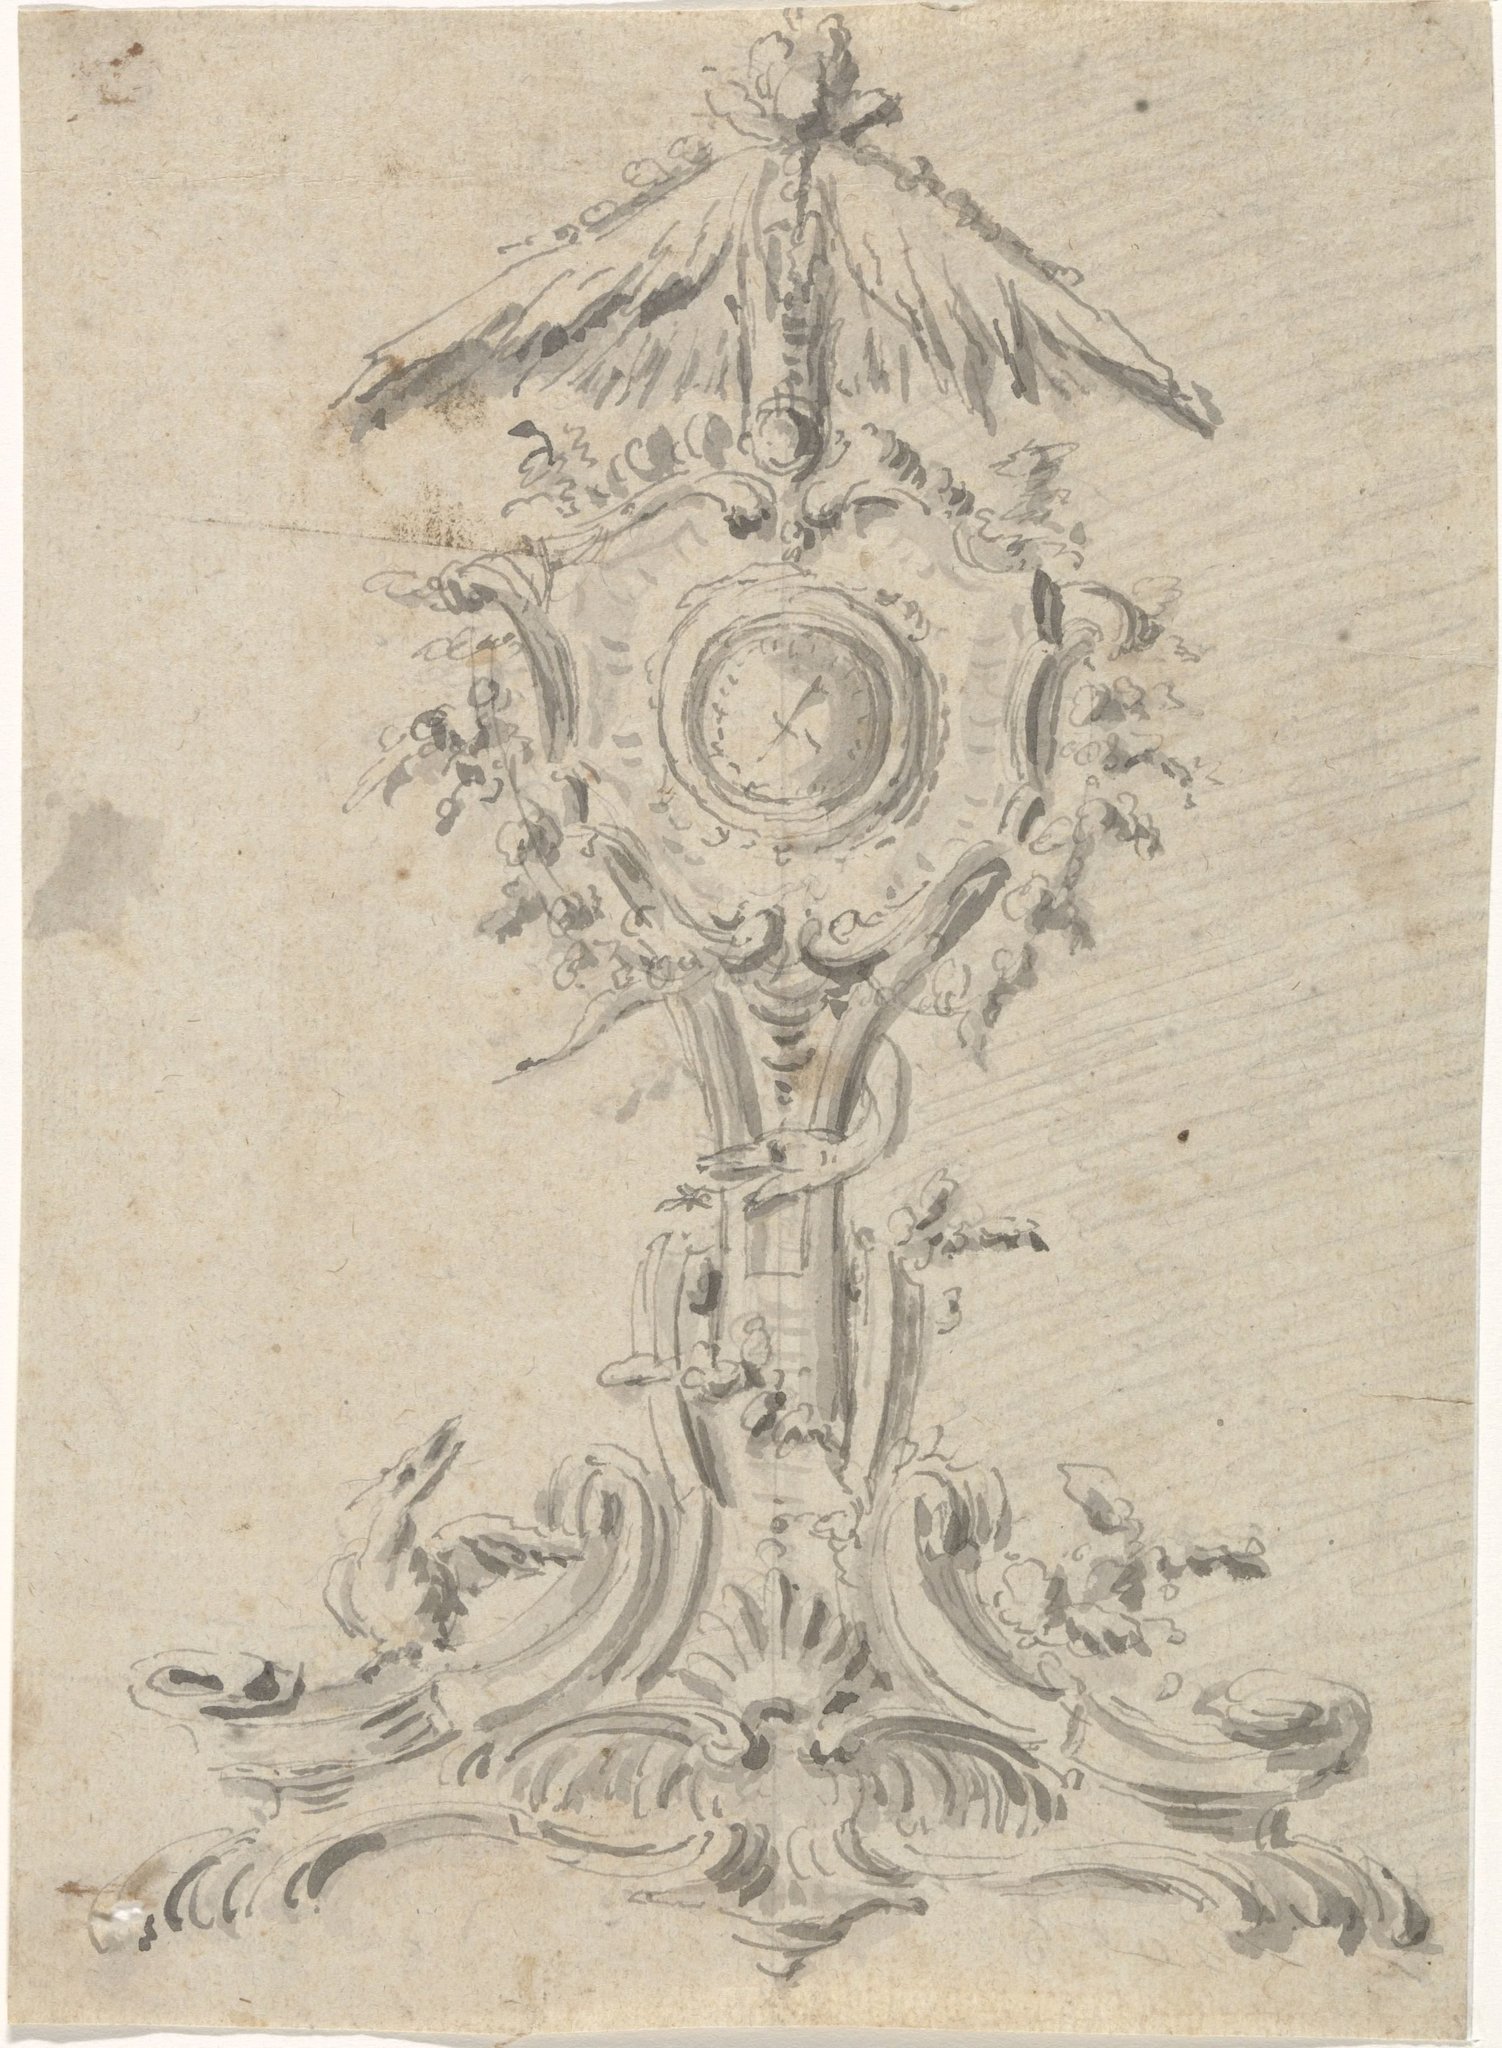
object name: design drawing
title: Ontwerp voor een horlogestandaard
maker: thomas johnson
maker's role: print maker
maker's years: 1714-1778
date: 1760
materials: graphite, ink, paper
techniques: brush, pen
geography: london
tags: clock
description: Ontwerp voor een horlogestandaard met een slang die een vogel doet opschrikken, bekroond door een strooien dak.